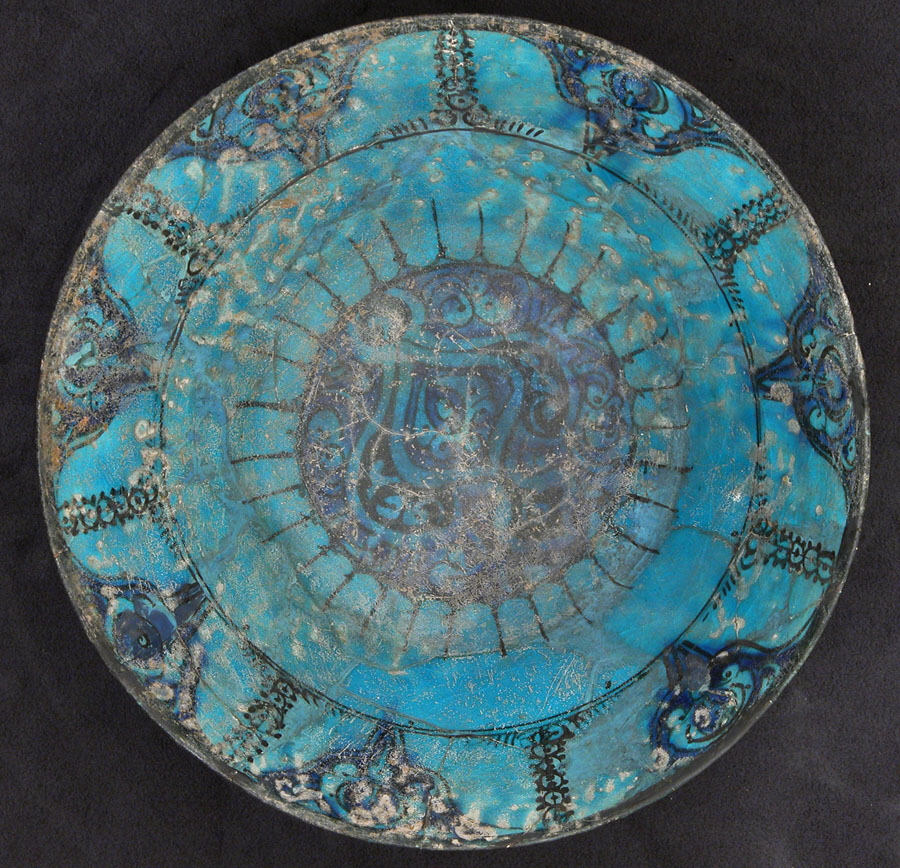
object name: bowl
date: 1201-1300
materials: stonepaste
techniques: painting, underglaze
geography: iran